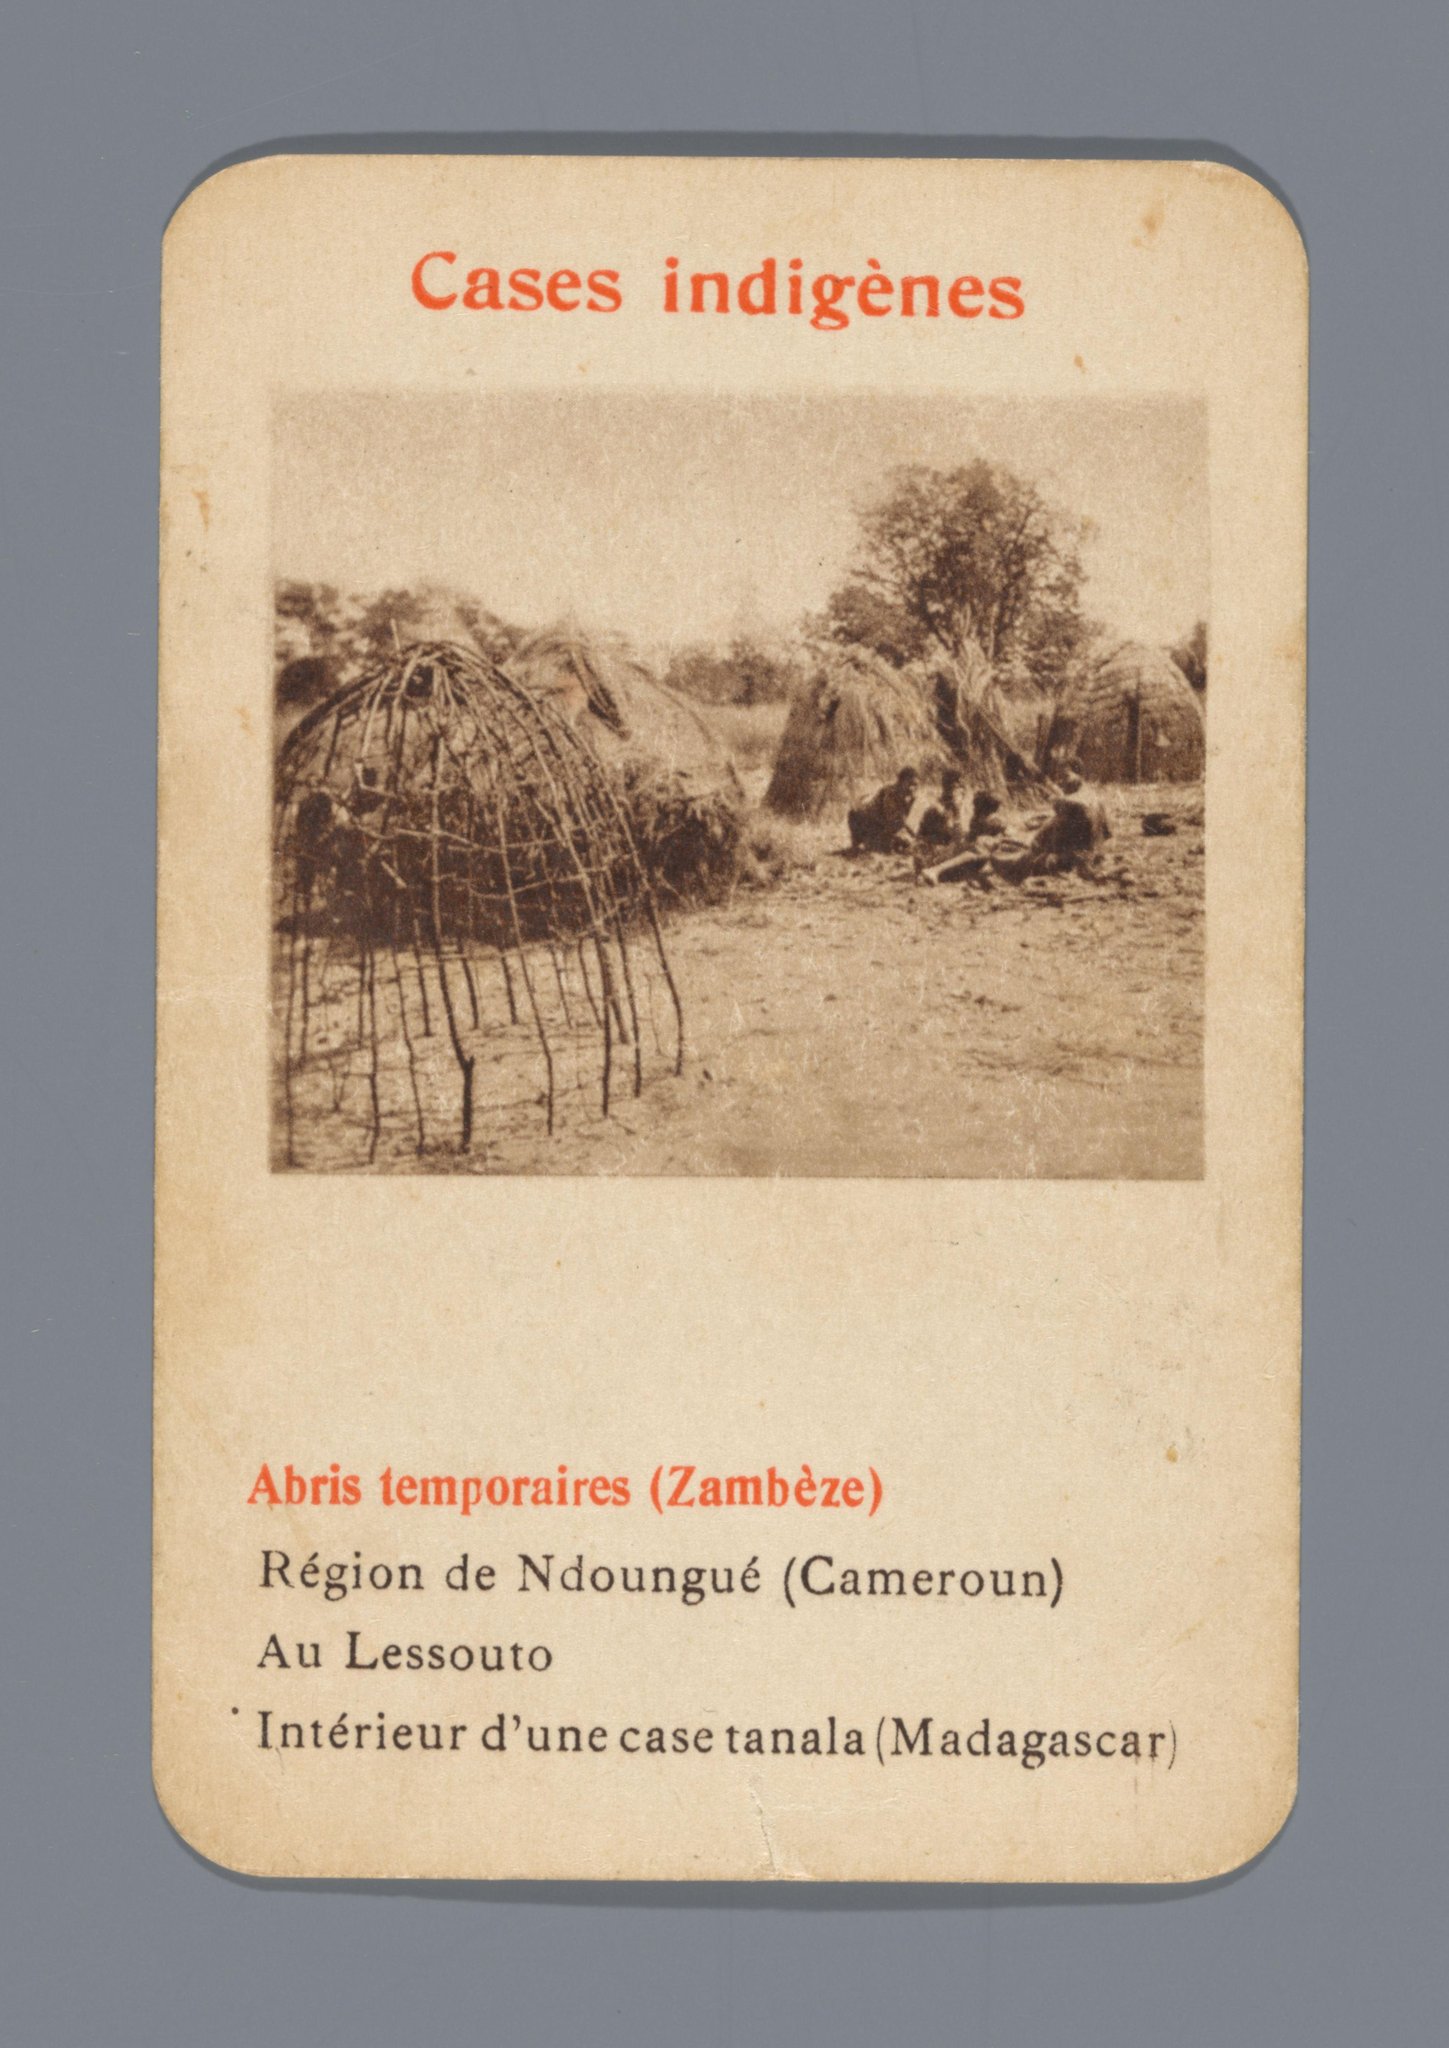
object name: card game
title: Abris temporaires (Zambèze)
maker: Anonymous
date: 1900-1920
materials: cardboard, paper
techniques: rotogravure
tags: card games, other dwelling types